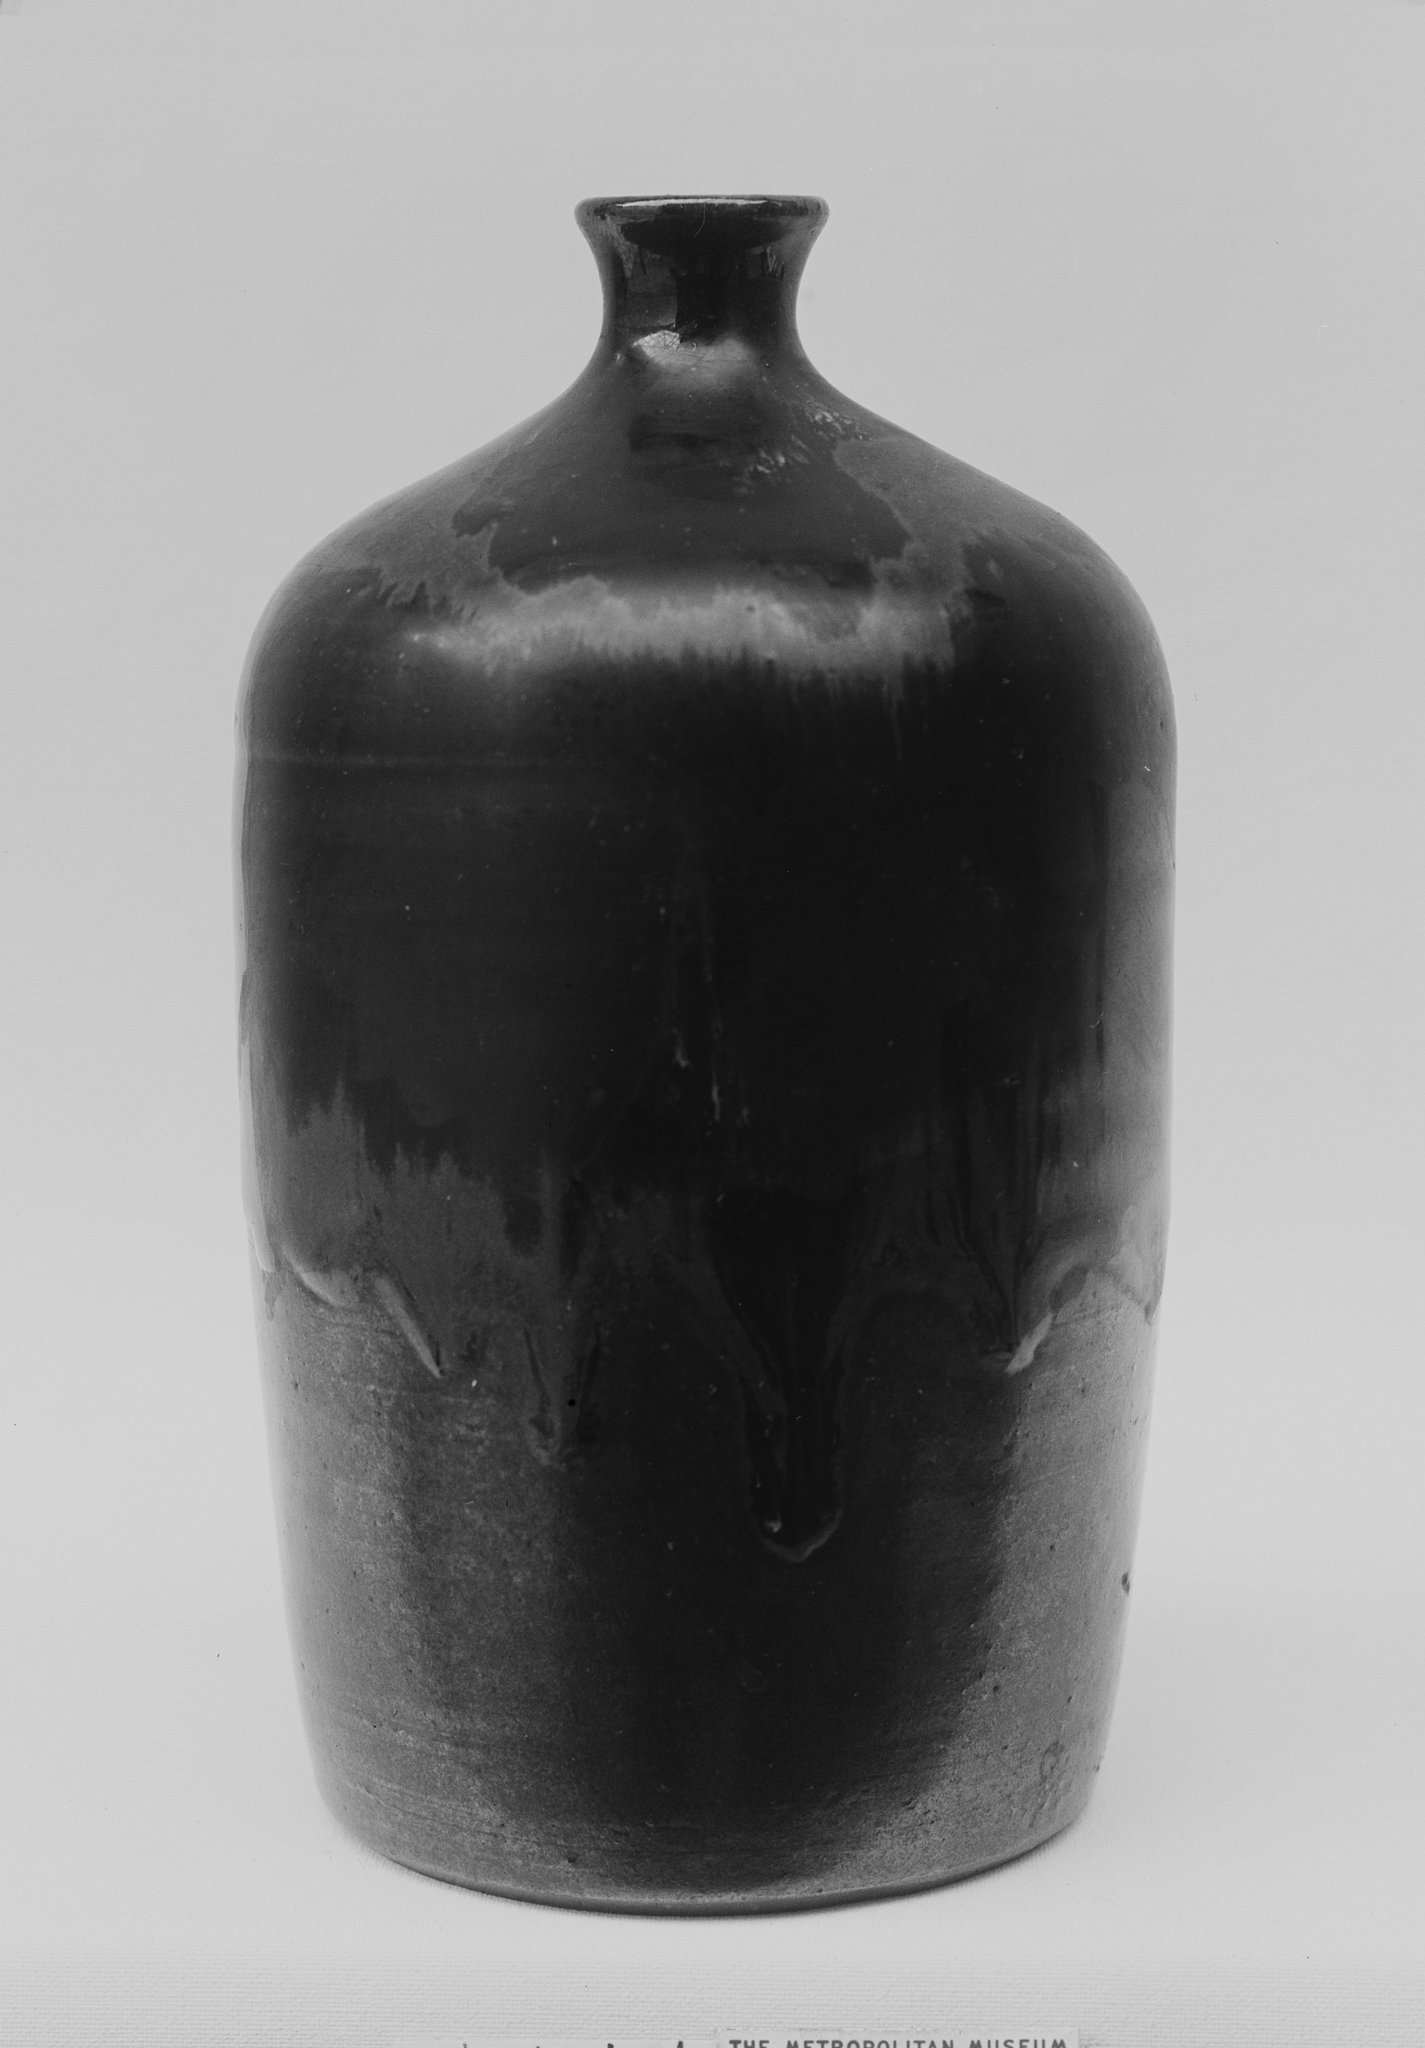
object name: bottle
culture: japanese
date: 1700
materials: clay, glaze